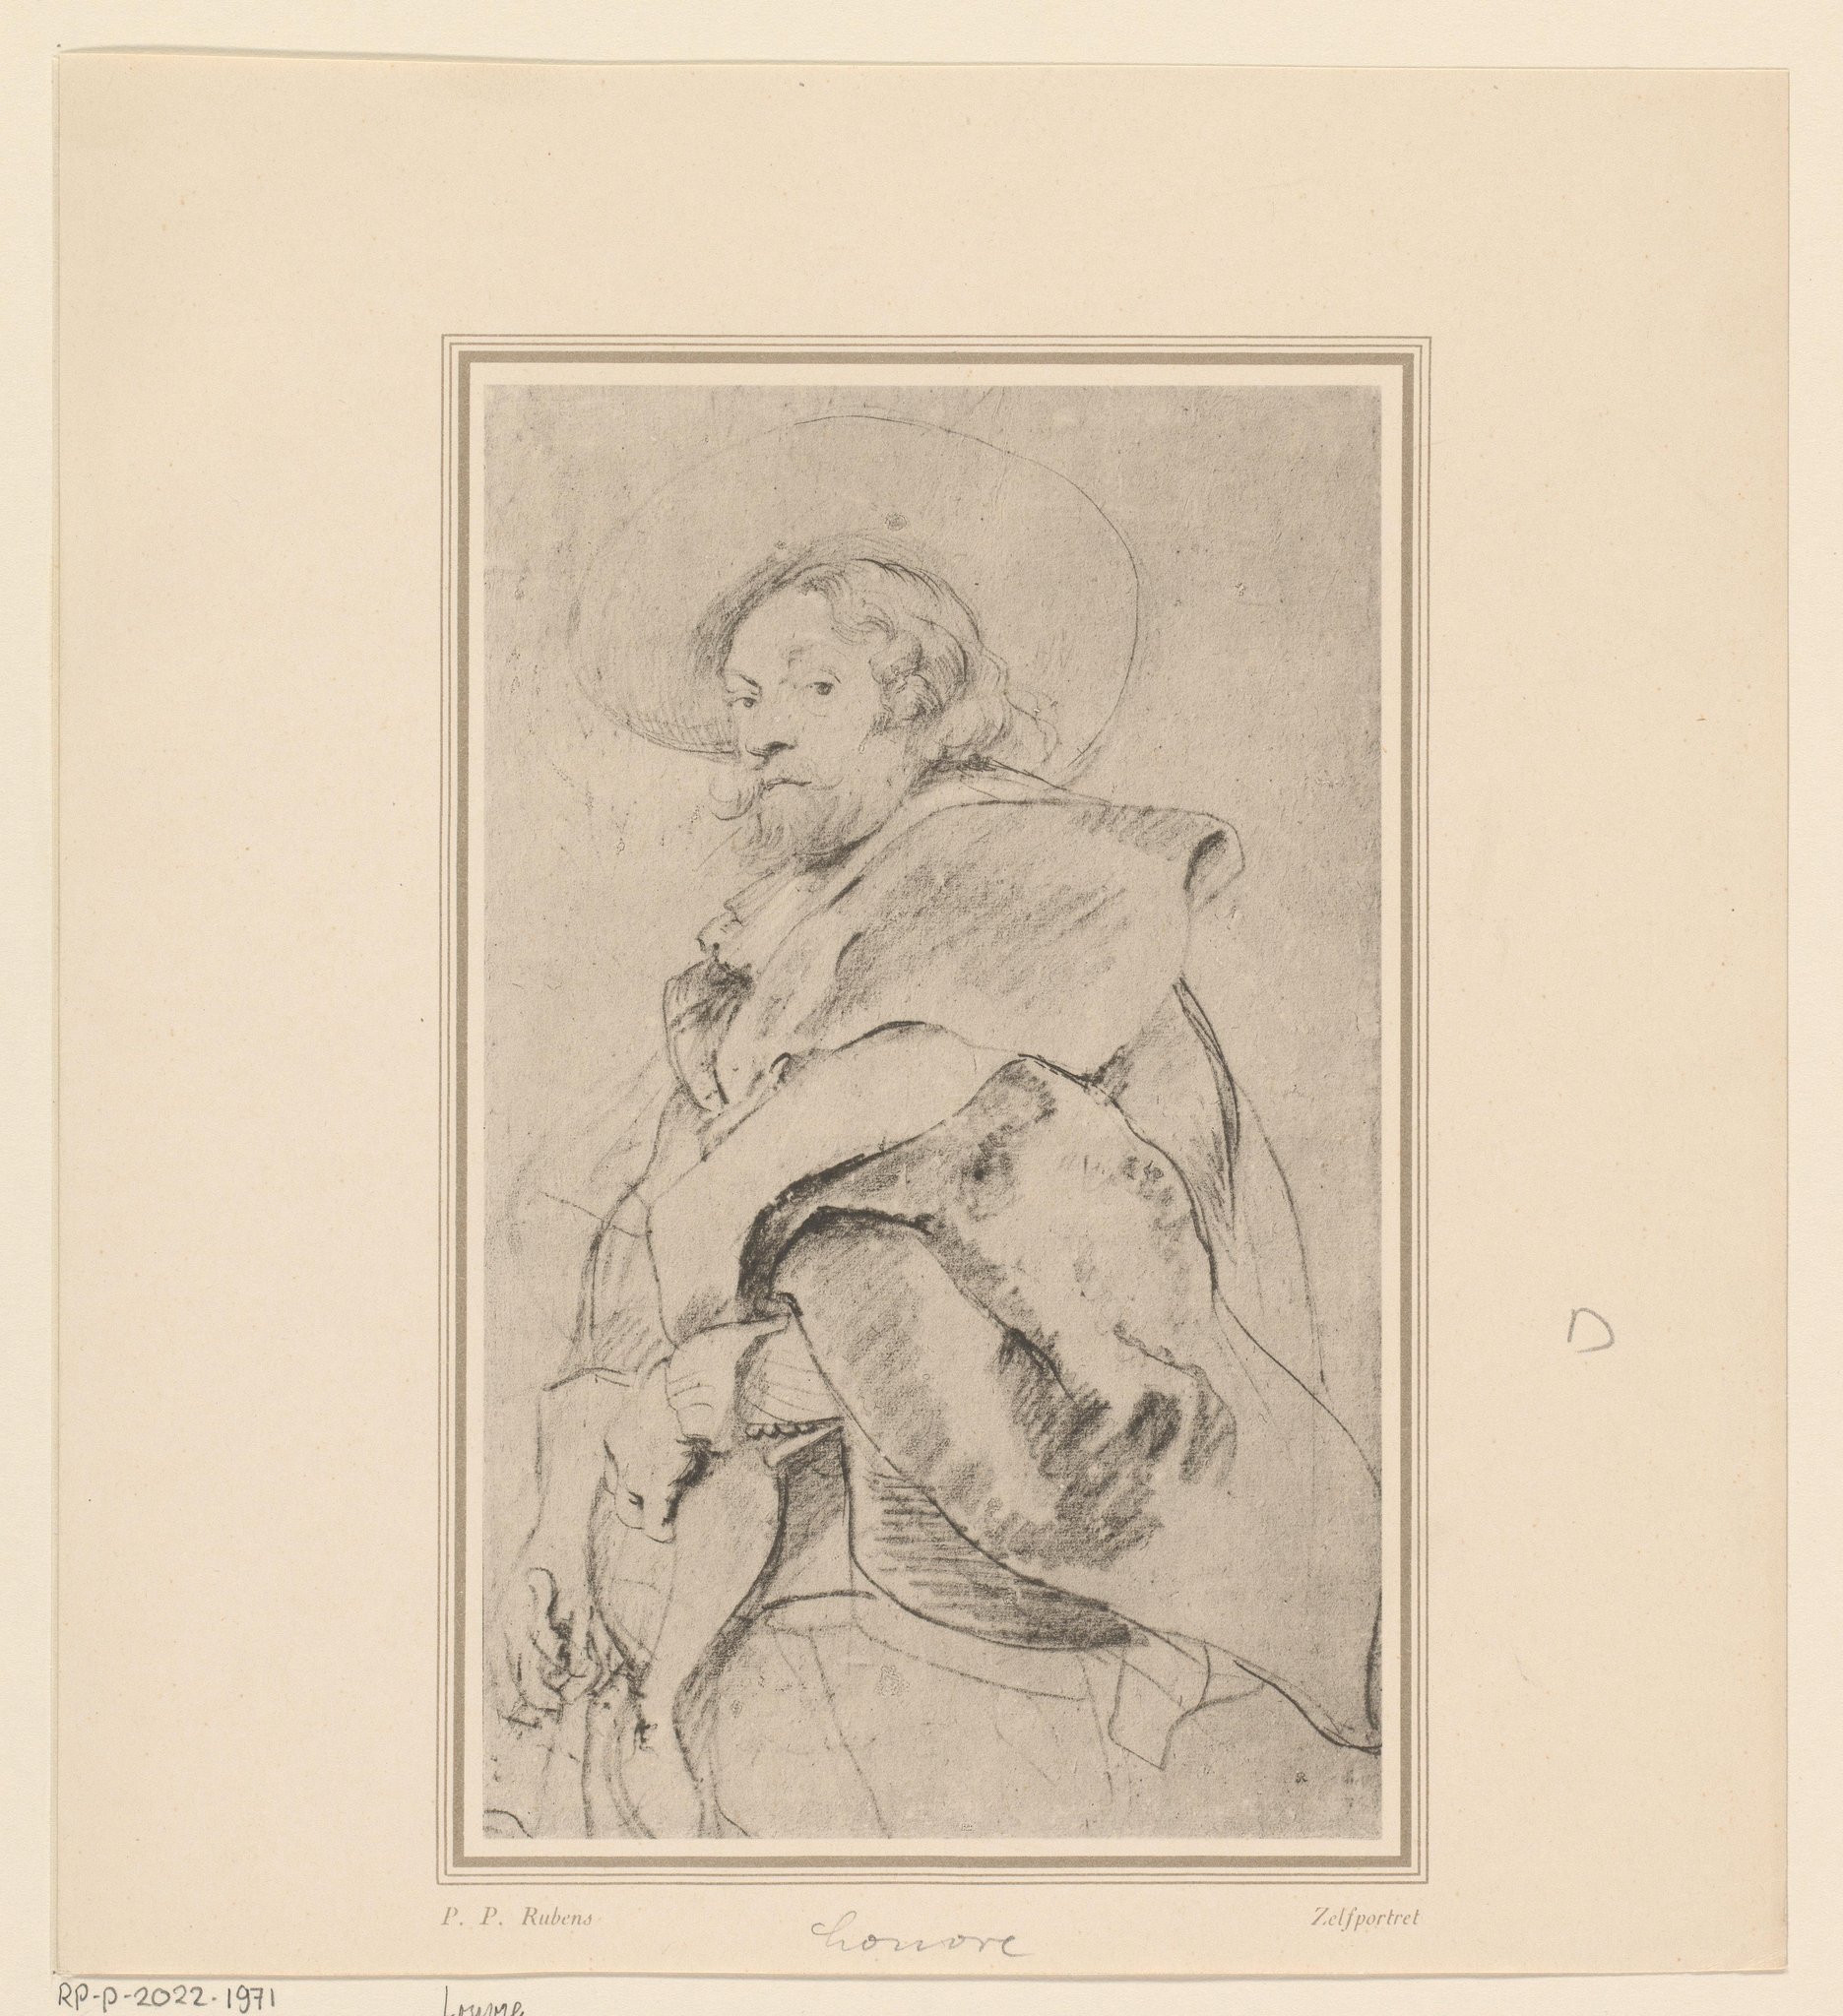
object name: photomechanical print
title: Zelfportret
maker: Anonymous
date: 1875-1930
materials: paper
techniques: photograph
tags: antwerp, painter, print maker, draughtsman, peter paul rubens, historical persons, portrait, self-portrait of artist